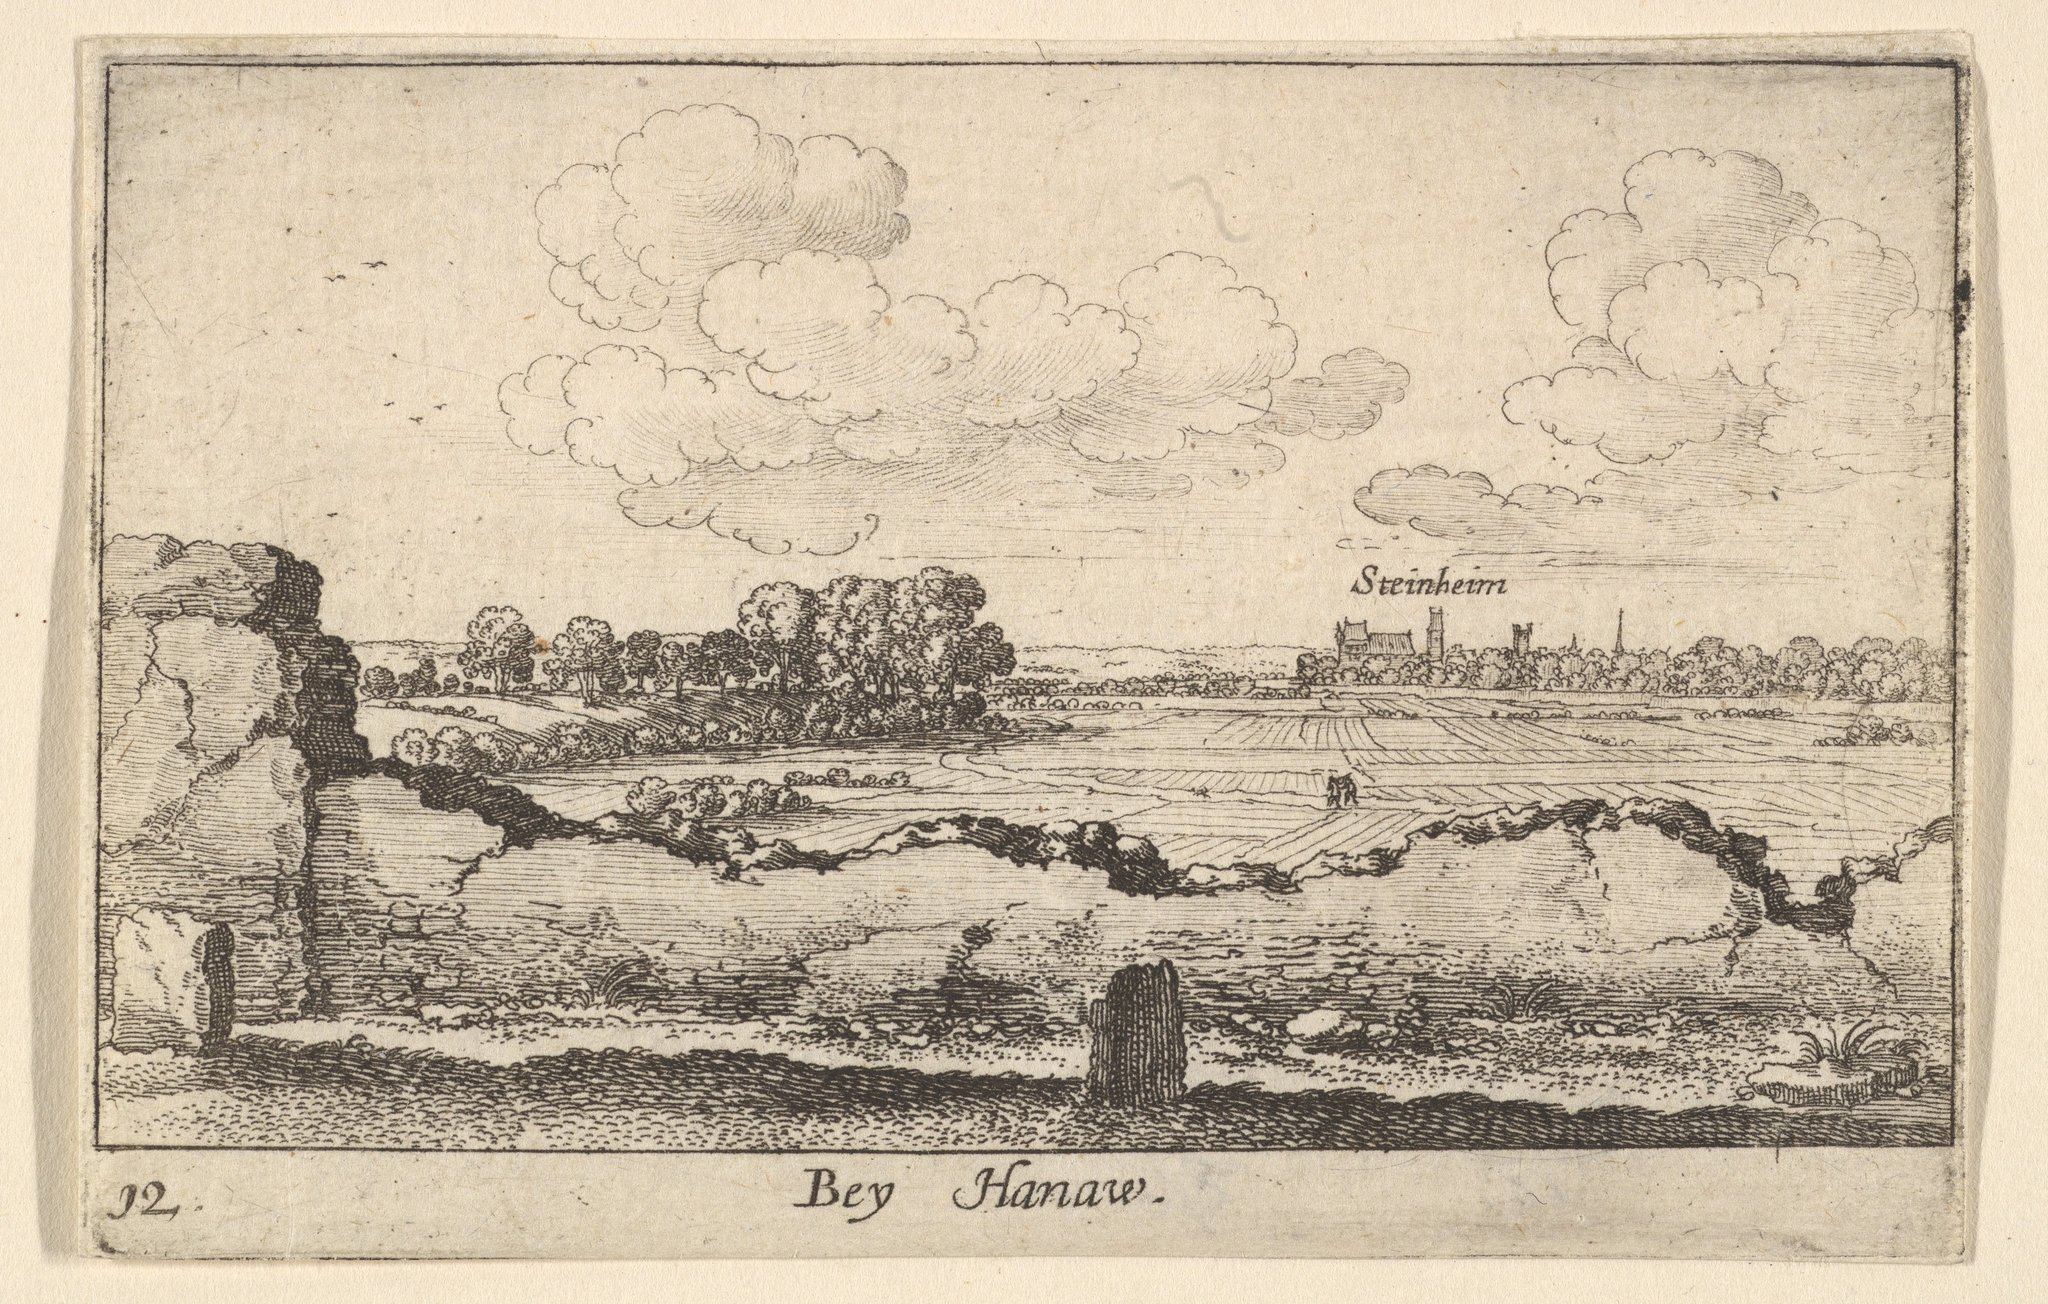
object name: print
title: Hanau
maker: wenceslaus hollar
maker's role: artist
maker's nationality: bohemian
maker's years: 1607-1677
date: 1635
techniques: etching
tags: ruins,trees